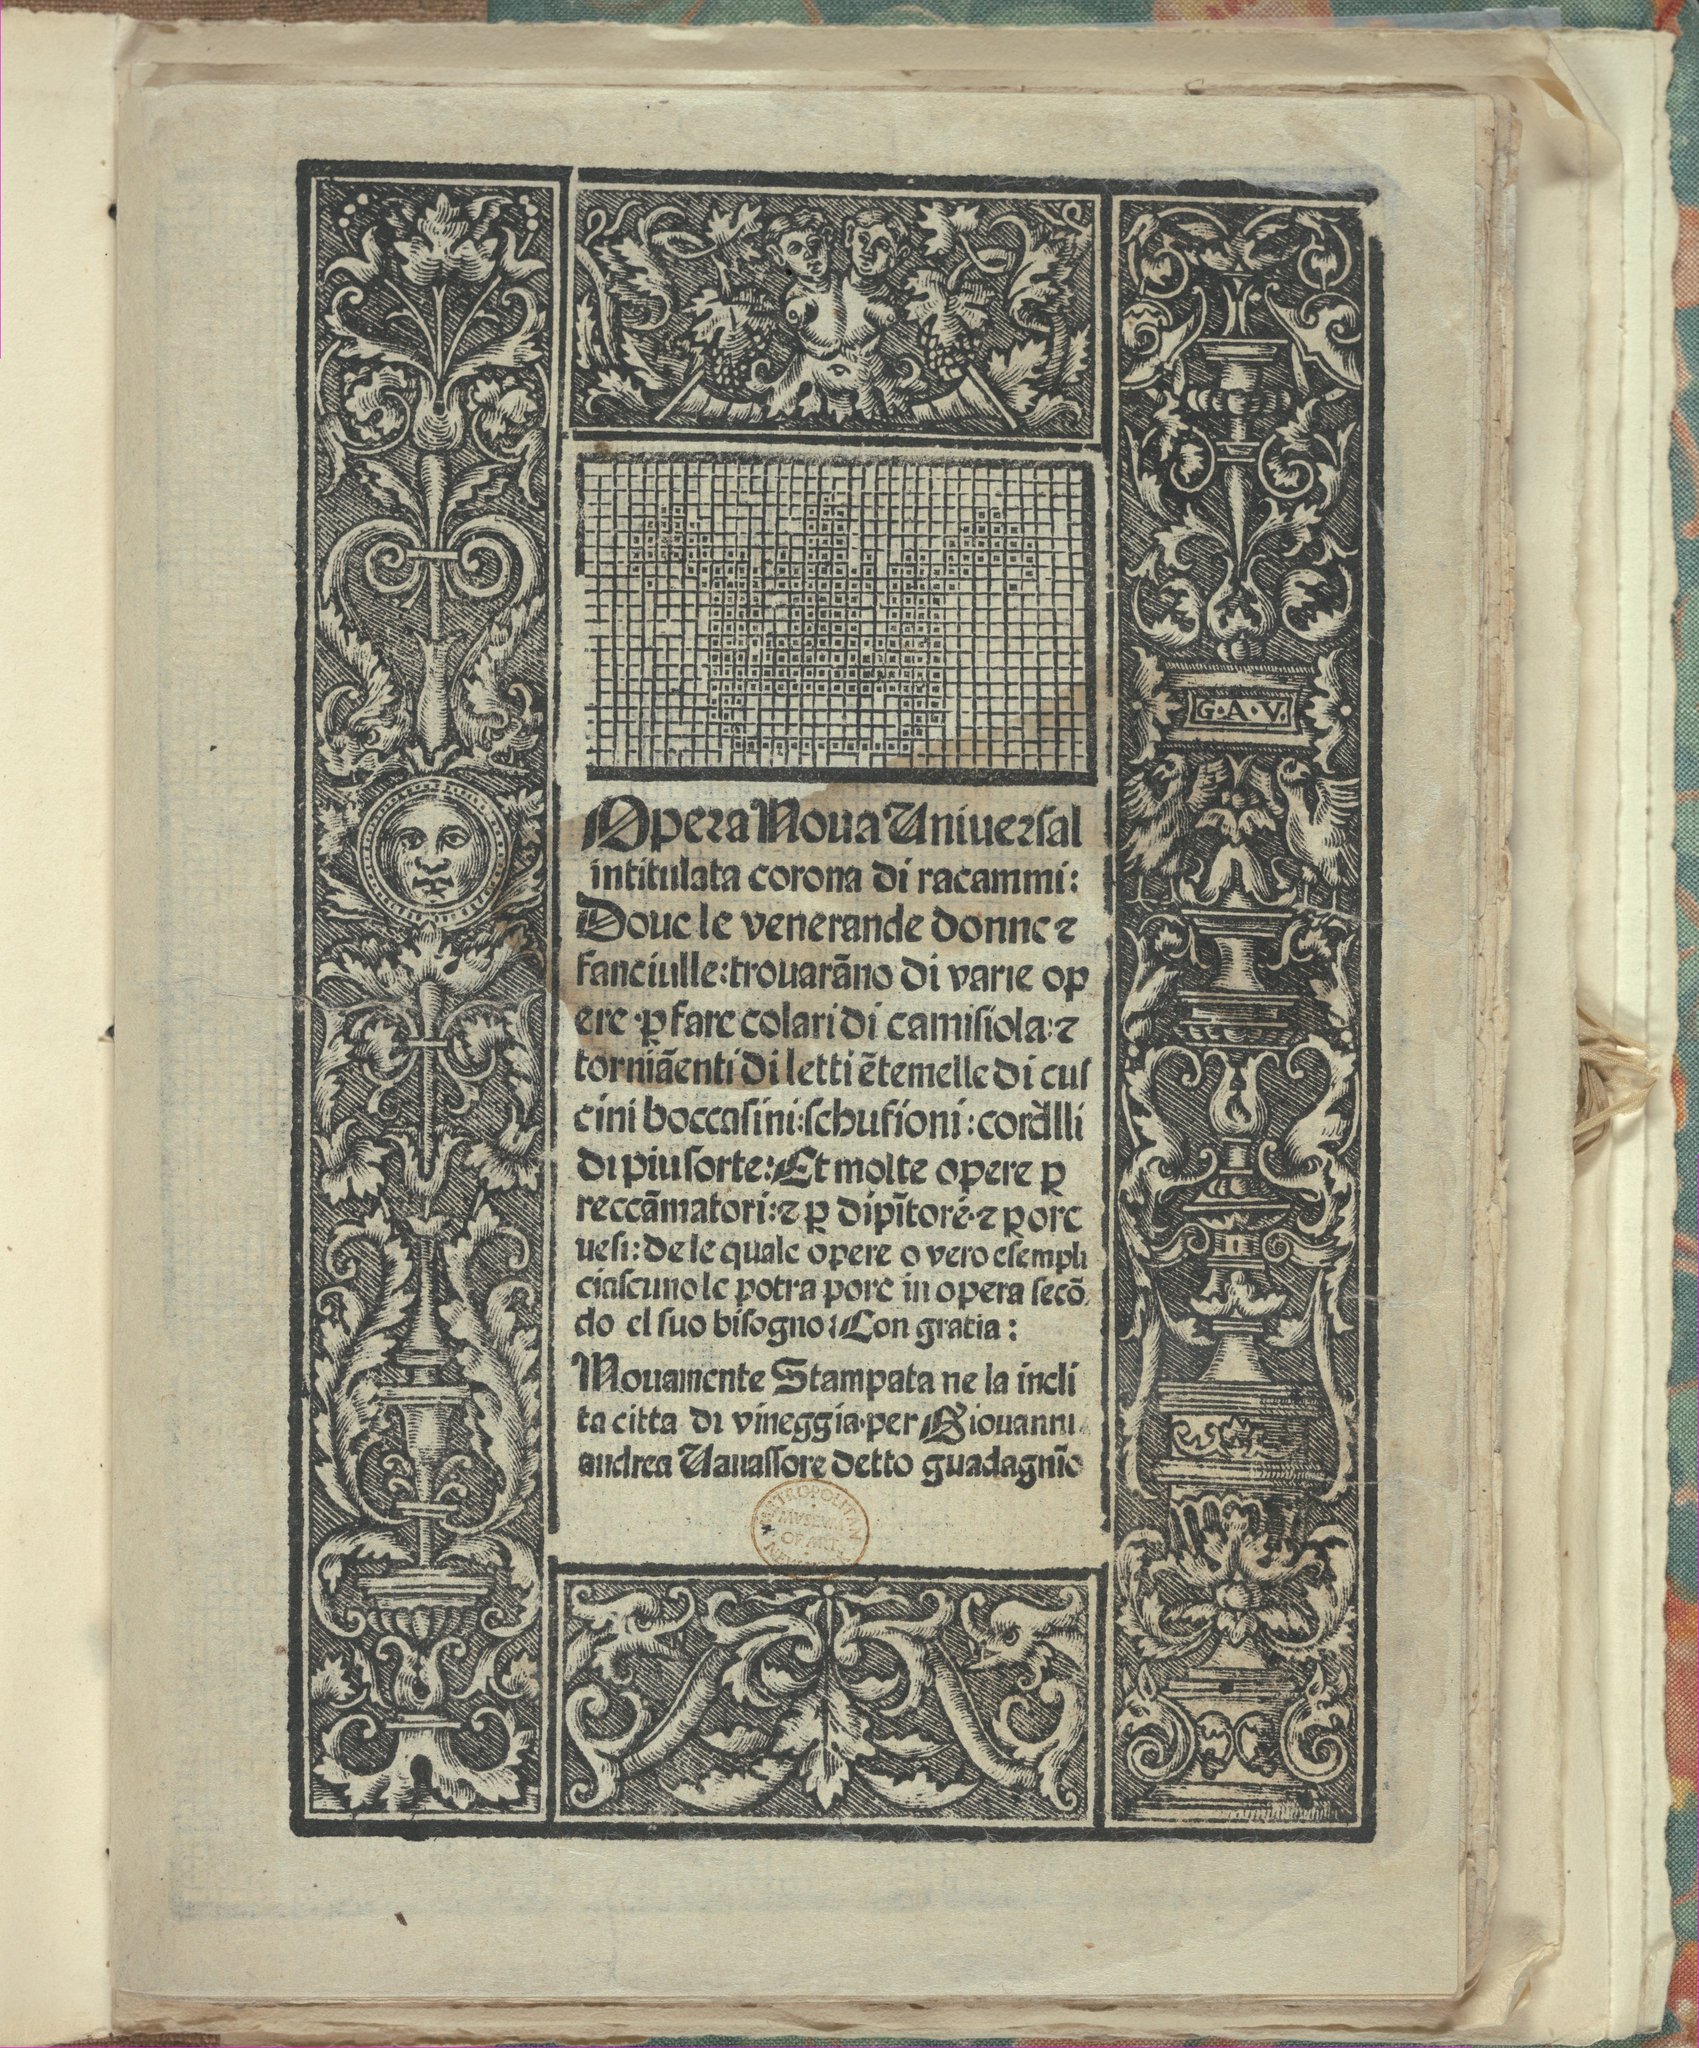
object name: book print ornament architecture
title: Opera Nova Universali intitulata Corona di racammi, title page (recto)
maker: giovanni andrea vavassore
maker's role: publisher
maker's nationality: italian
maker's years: 1530-1573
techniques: woodcut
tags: faces